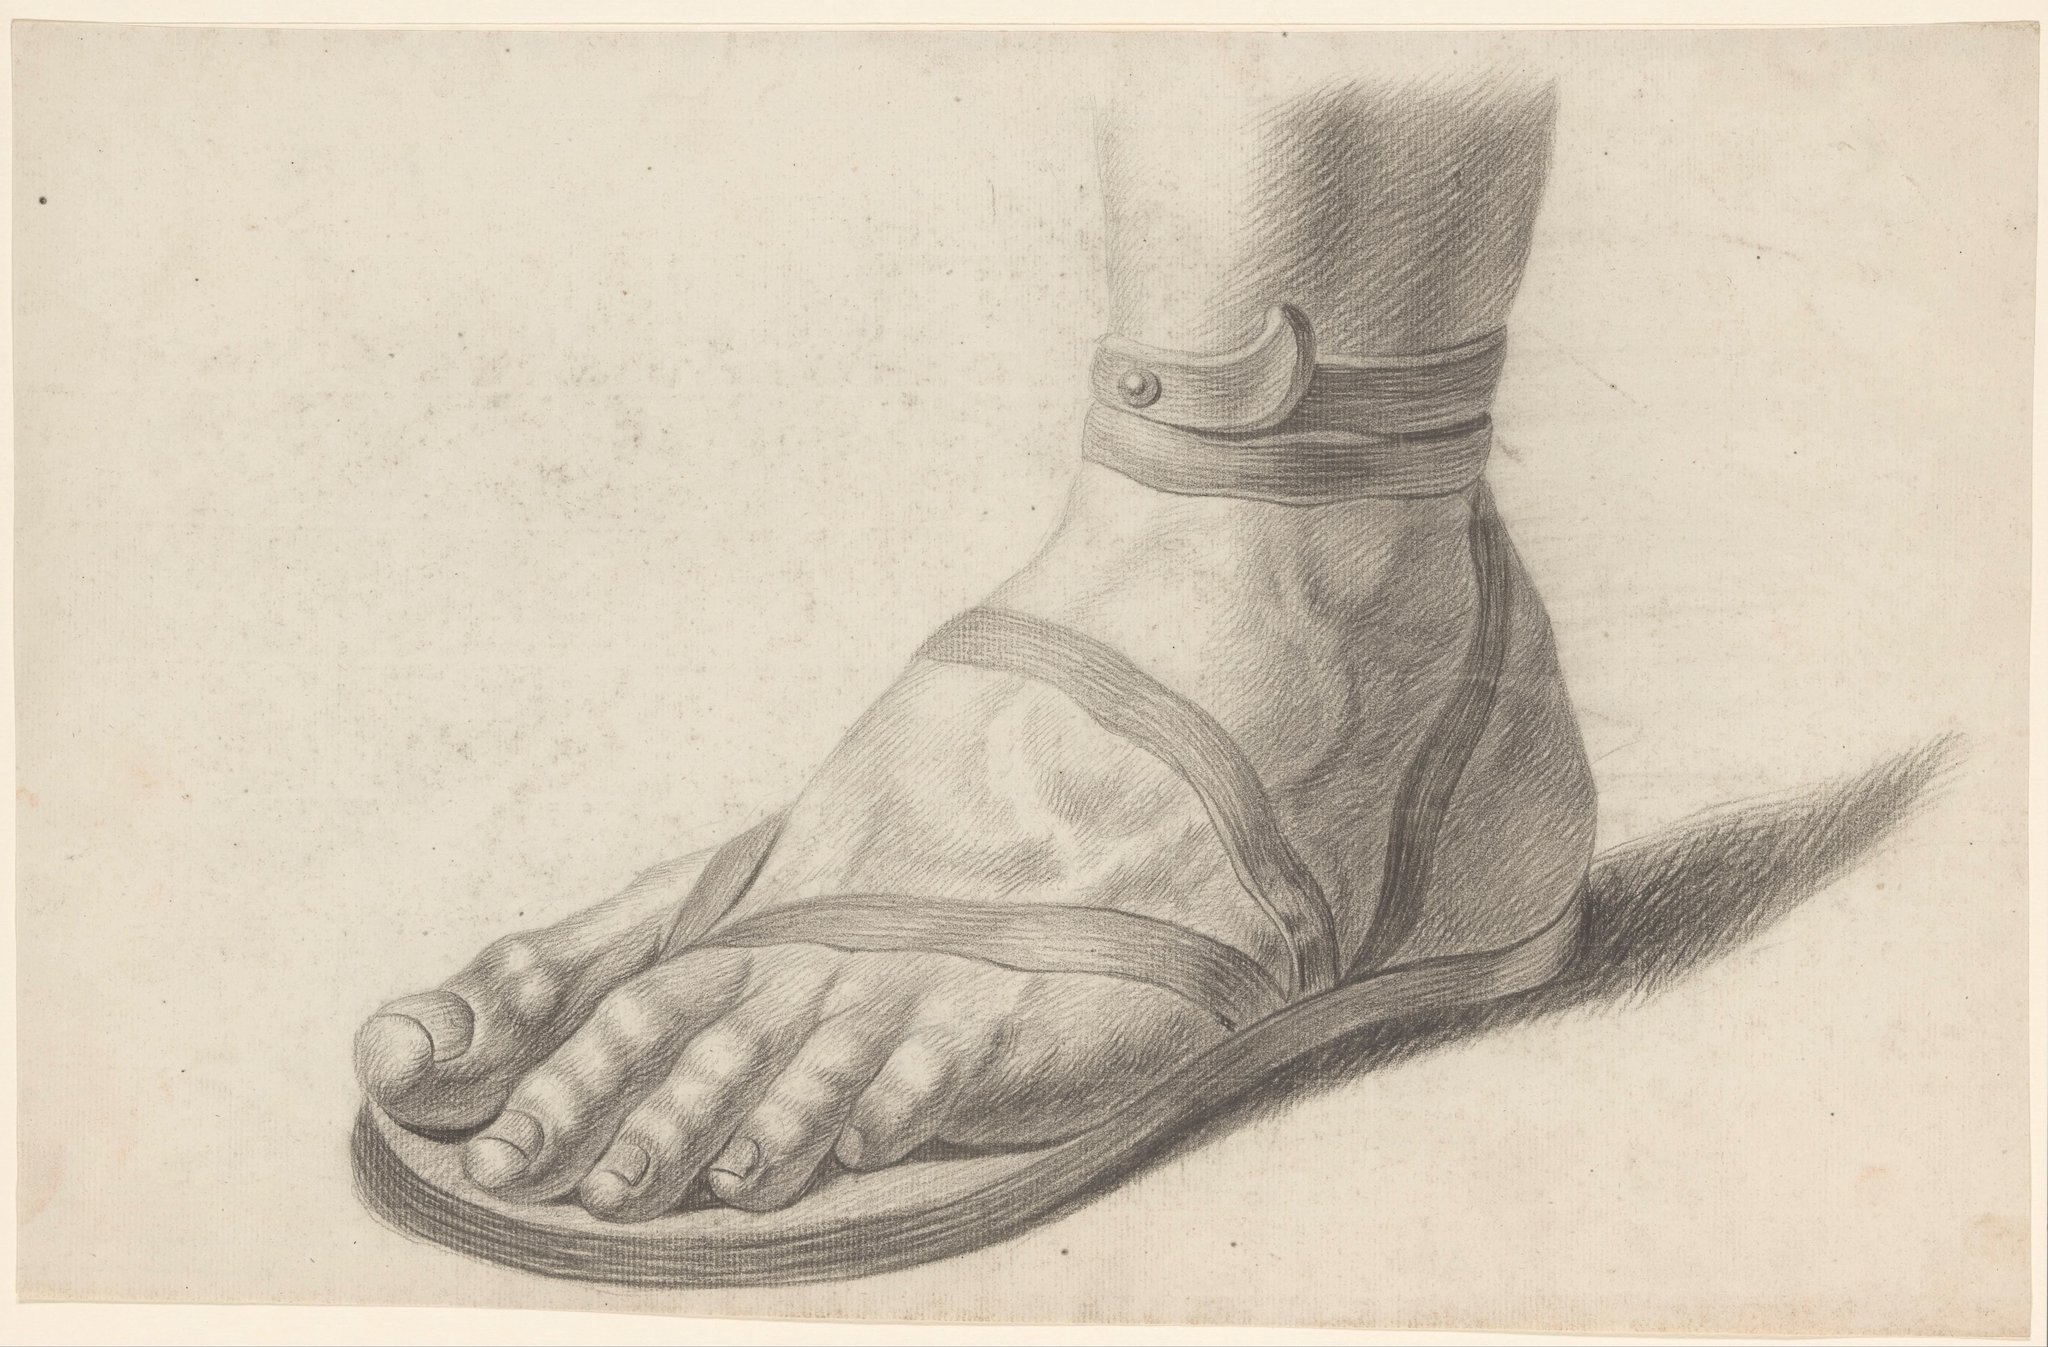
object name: figuurstudie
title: Academiestudie naar een gips van een antiek beeld: detailstudie van een voet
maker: johannes tavenraat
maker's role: draughtsman, painter, print maker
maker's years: 1809-1881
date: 1819-1881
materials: chalk, paper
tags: piece of sculpture, reproduction of a piece of sculpture (+ ceramics ~ arts)